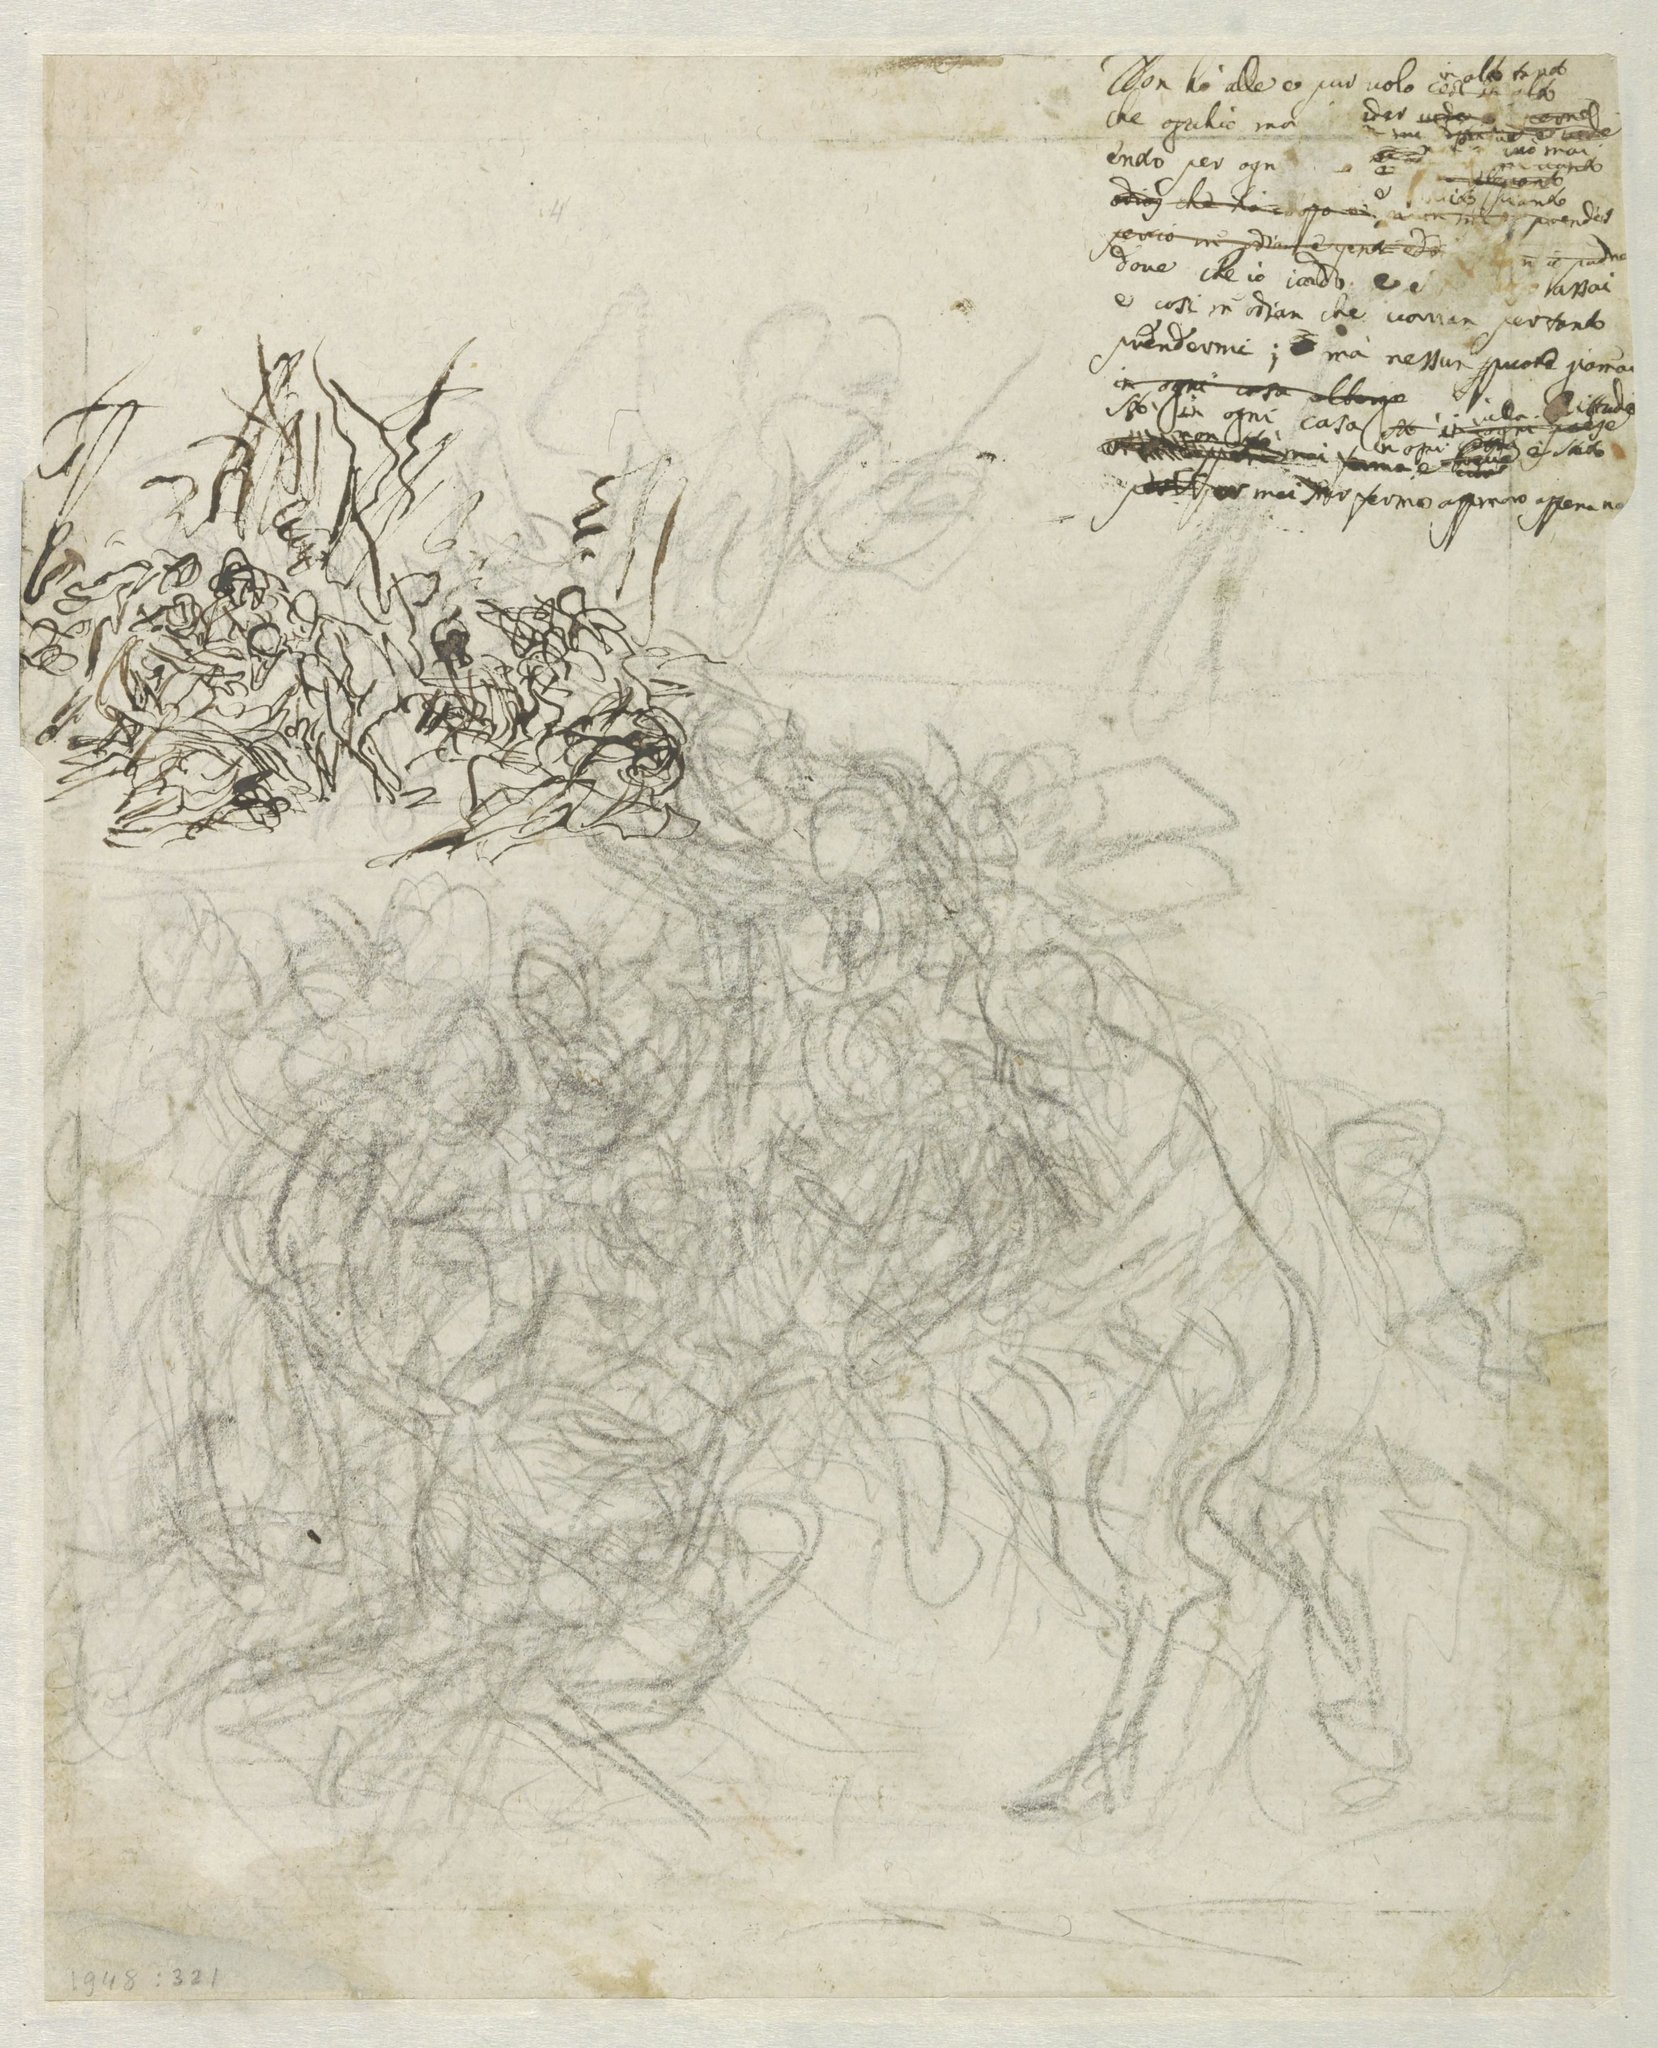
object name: drawing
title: Twee schetsen van het vinden van Mozes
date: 1719-1769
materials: chalk, ink, paper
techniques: pen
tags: the finding of moses: pharaoh's daughter comes to bathe with her maidens in the river and discovers the child floating on the water